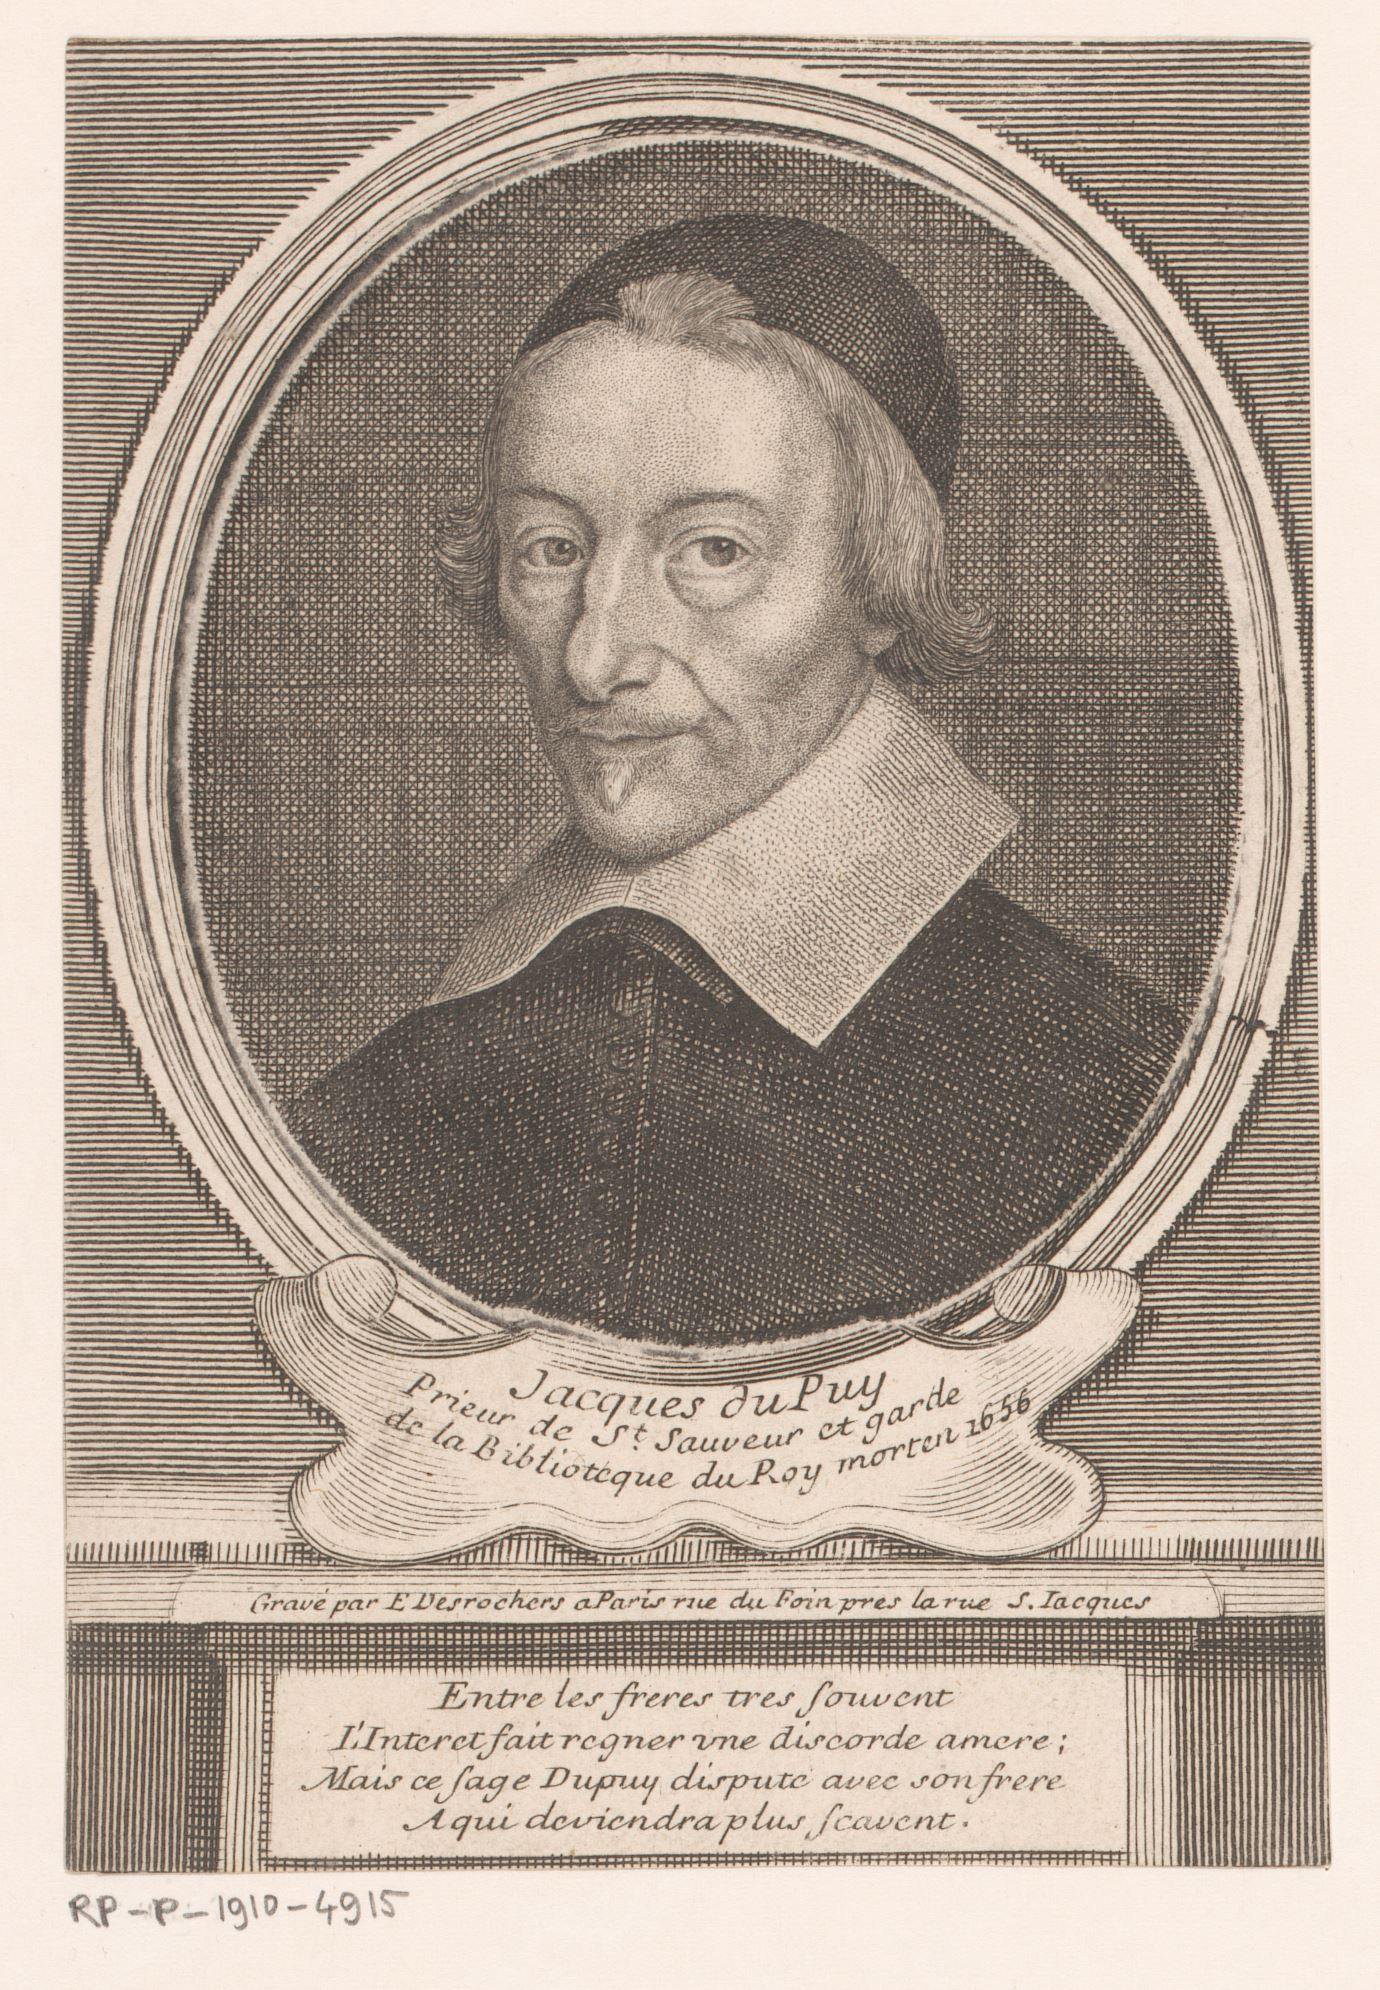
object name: print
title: Recueil de portraits (...)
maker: étienne desrochers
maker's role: print maker, publisher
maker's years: 1668-1741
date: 1726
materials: paper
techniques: engraving, etching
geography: paris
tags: paris, scholar, philosopher, historical persons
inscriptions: collector's mark: Lugt 2228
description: Behoort waarschijnlijk tot een serie portretten, grotendeels door Etienne Desrochers, getiteld: 'Recueil de portraits de personnes qui se sont distinguées tant dans les Armes que dans Belles-Lettres et les Arts, comme aussi la famille royale de France et autres cours étrangères'. De serie werd initieel uitgegeven door Desrochers en aangekondigd in 'Mercure' in mei 1726, p. 985. Echter was Desrochers reeds enkele jaren eerder begonnen met het uitgeven van de serie. Na de dood van Desrochers werd de serie voortgezet door Gilles Edme Petit. Een latere staat werd uitgegeven door Jean François Daumont in Parijs.